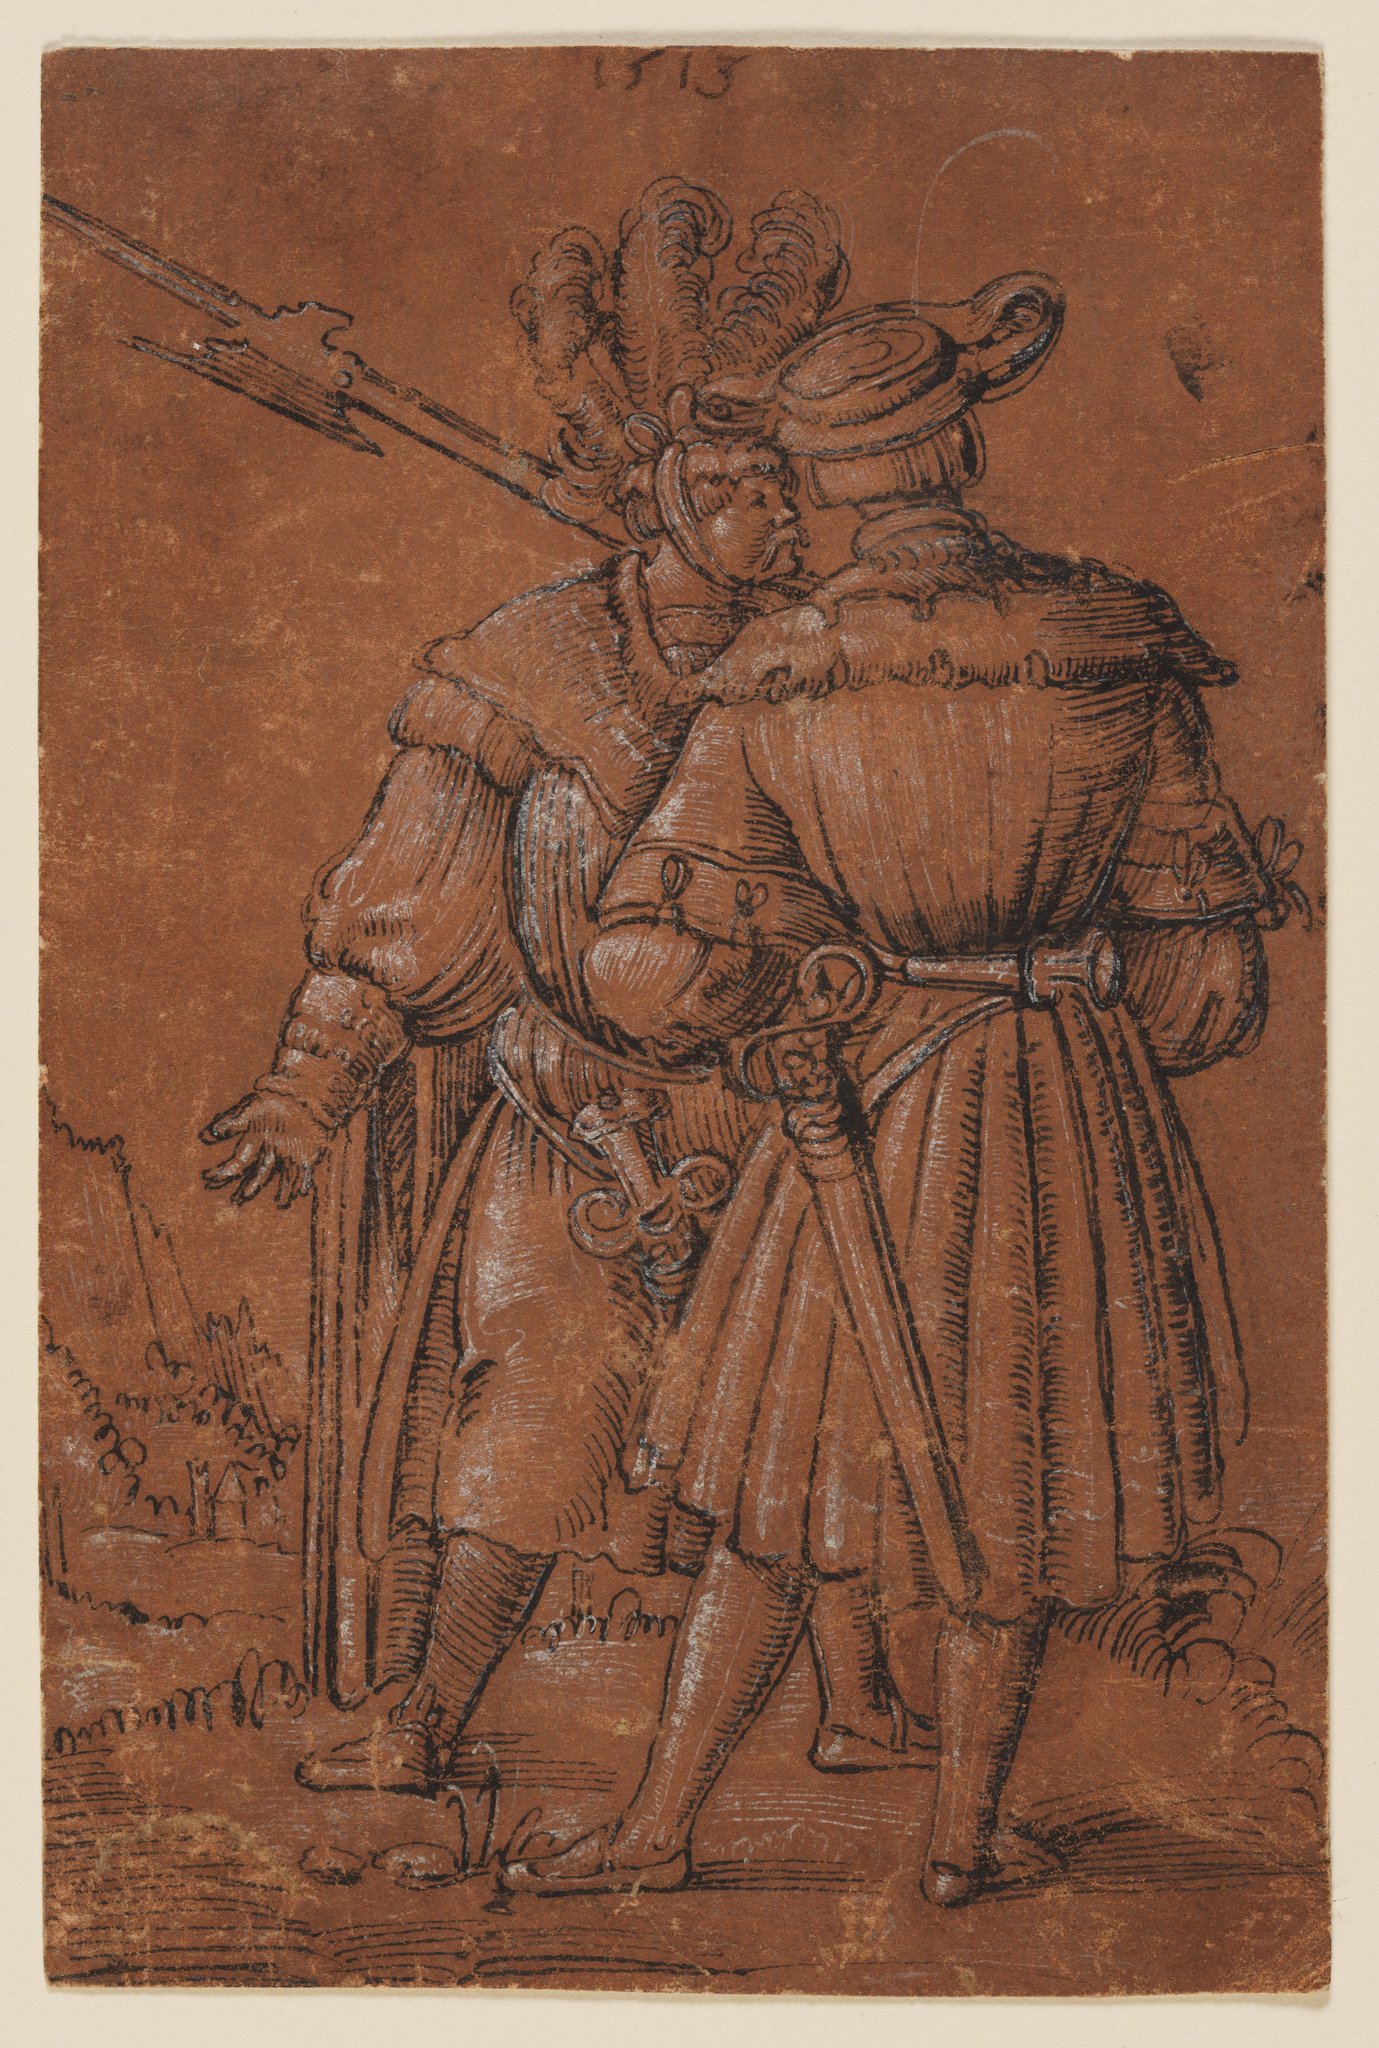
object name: drawing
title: Two Lansquenets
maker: erhard altdorfer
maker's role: artist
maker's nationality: german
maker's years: 1480-1562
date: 1513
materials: ink, paper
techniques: brush, highlighting, pen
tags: men